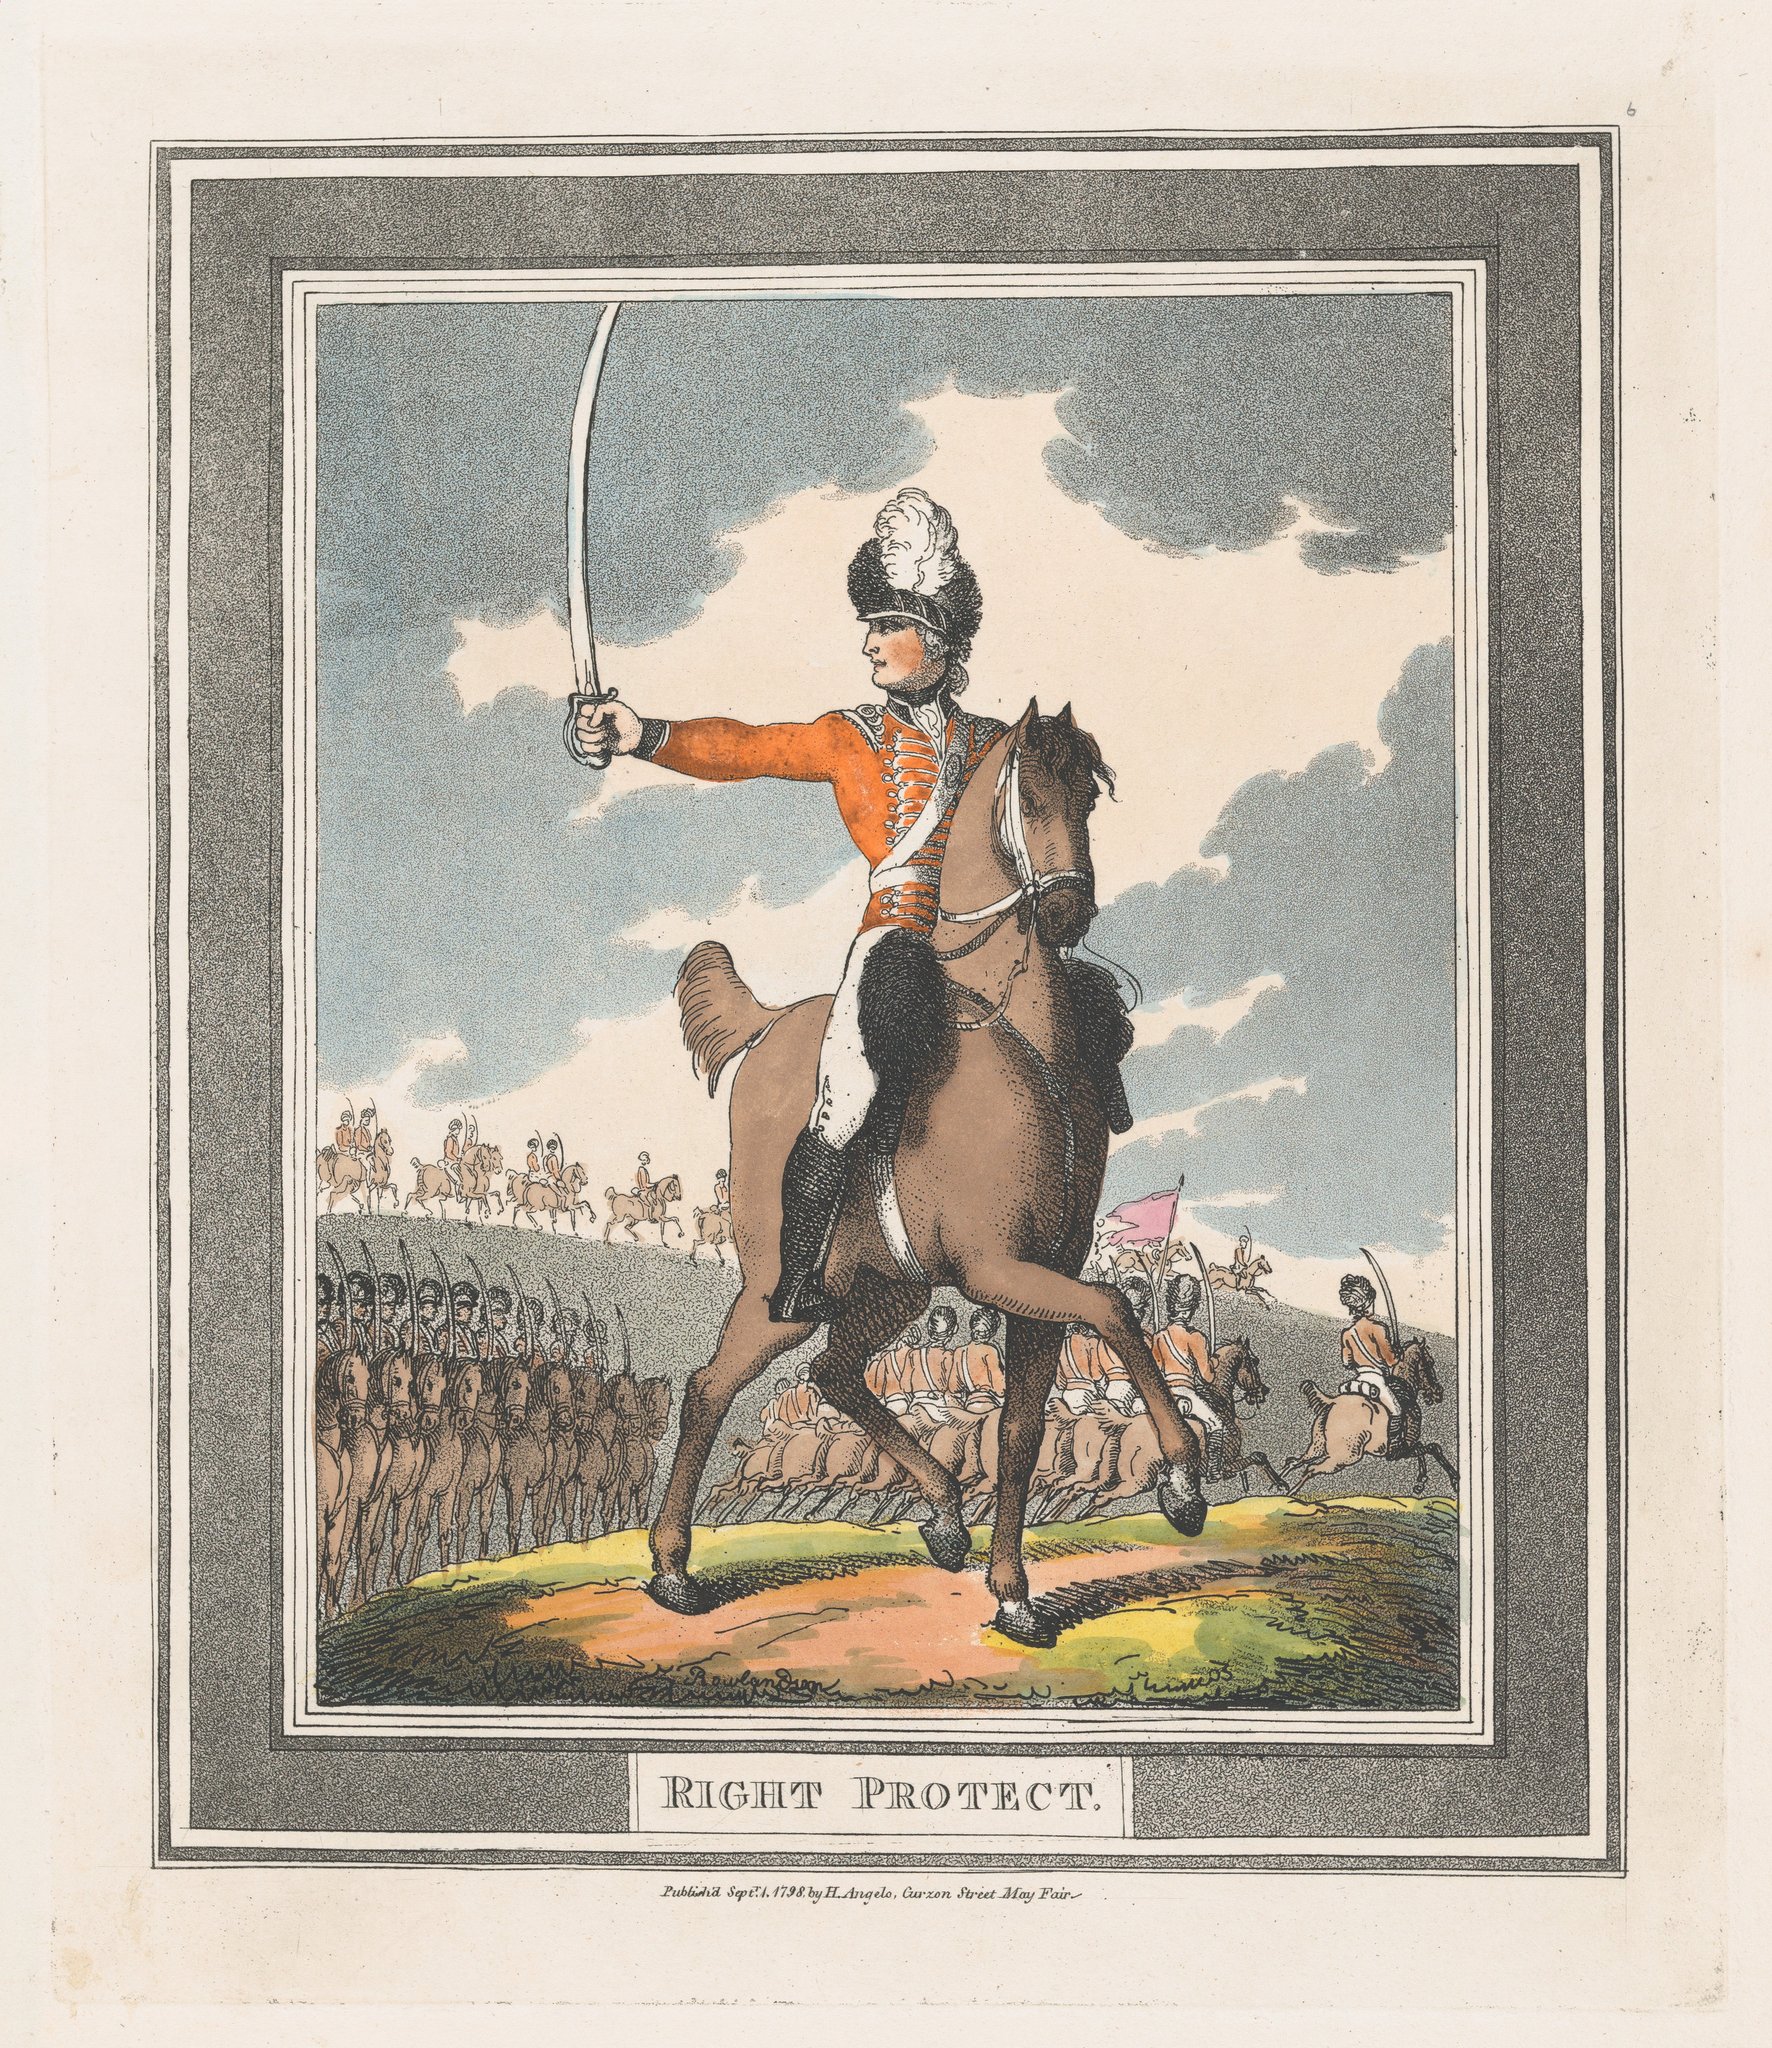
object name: print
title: Right Protect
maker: thomas rowlandson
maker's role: artist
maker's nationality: british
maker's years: 1757-1827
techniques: aquatint, etching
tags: soldiers,swords,men,horses